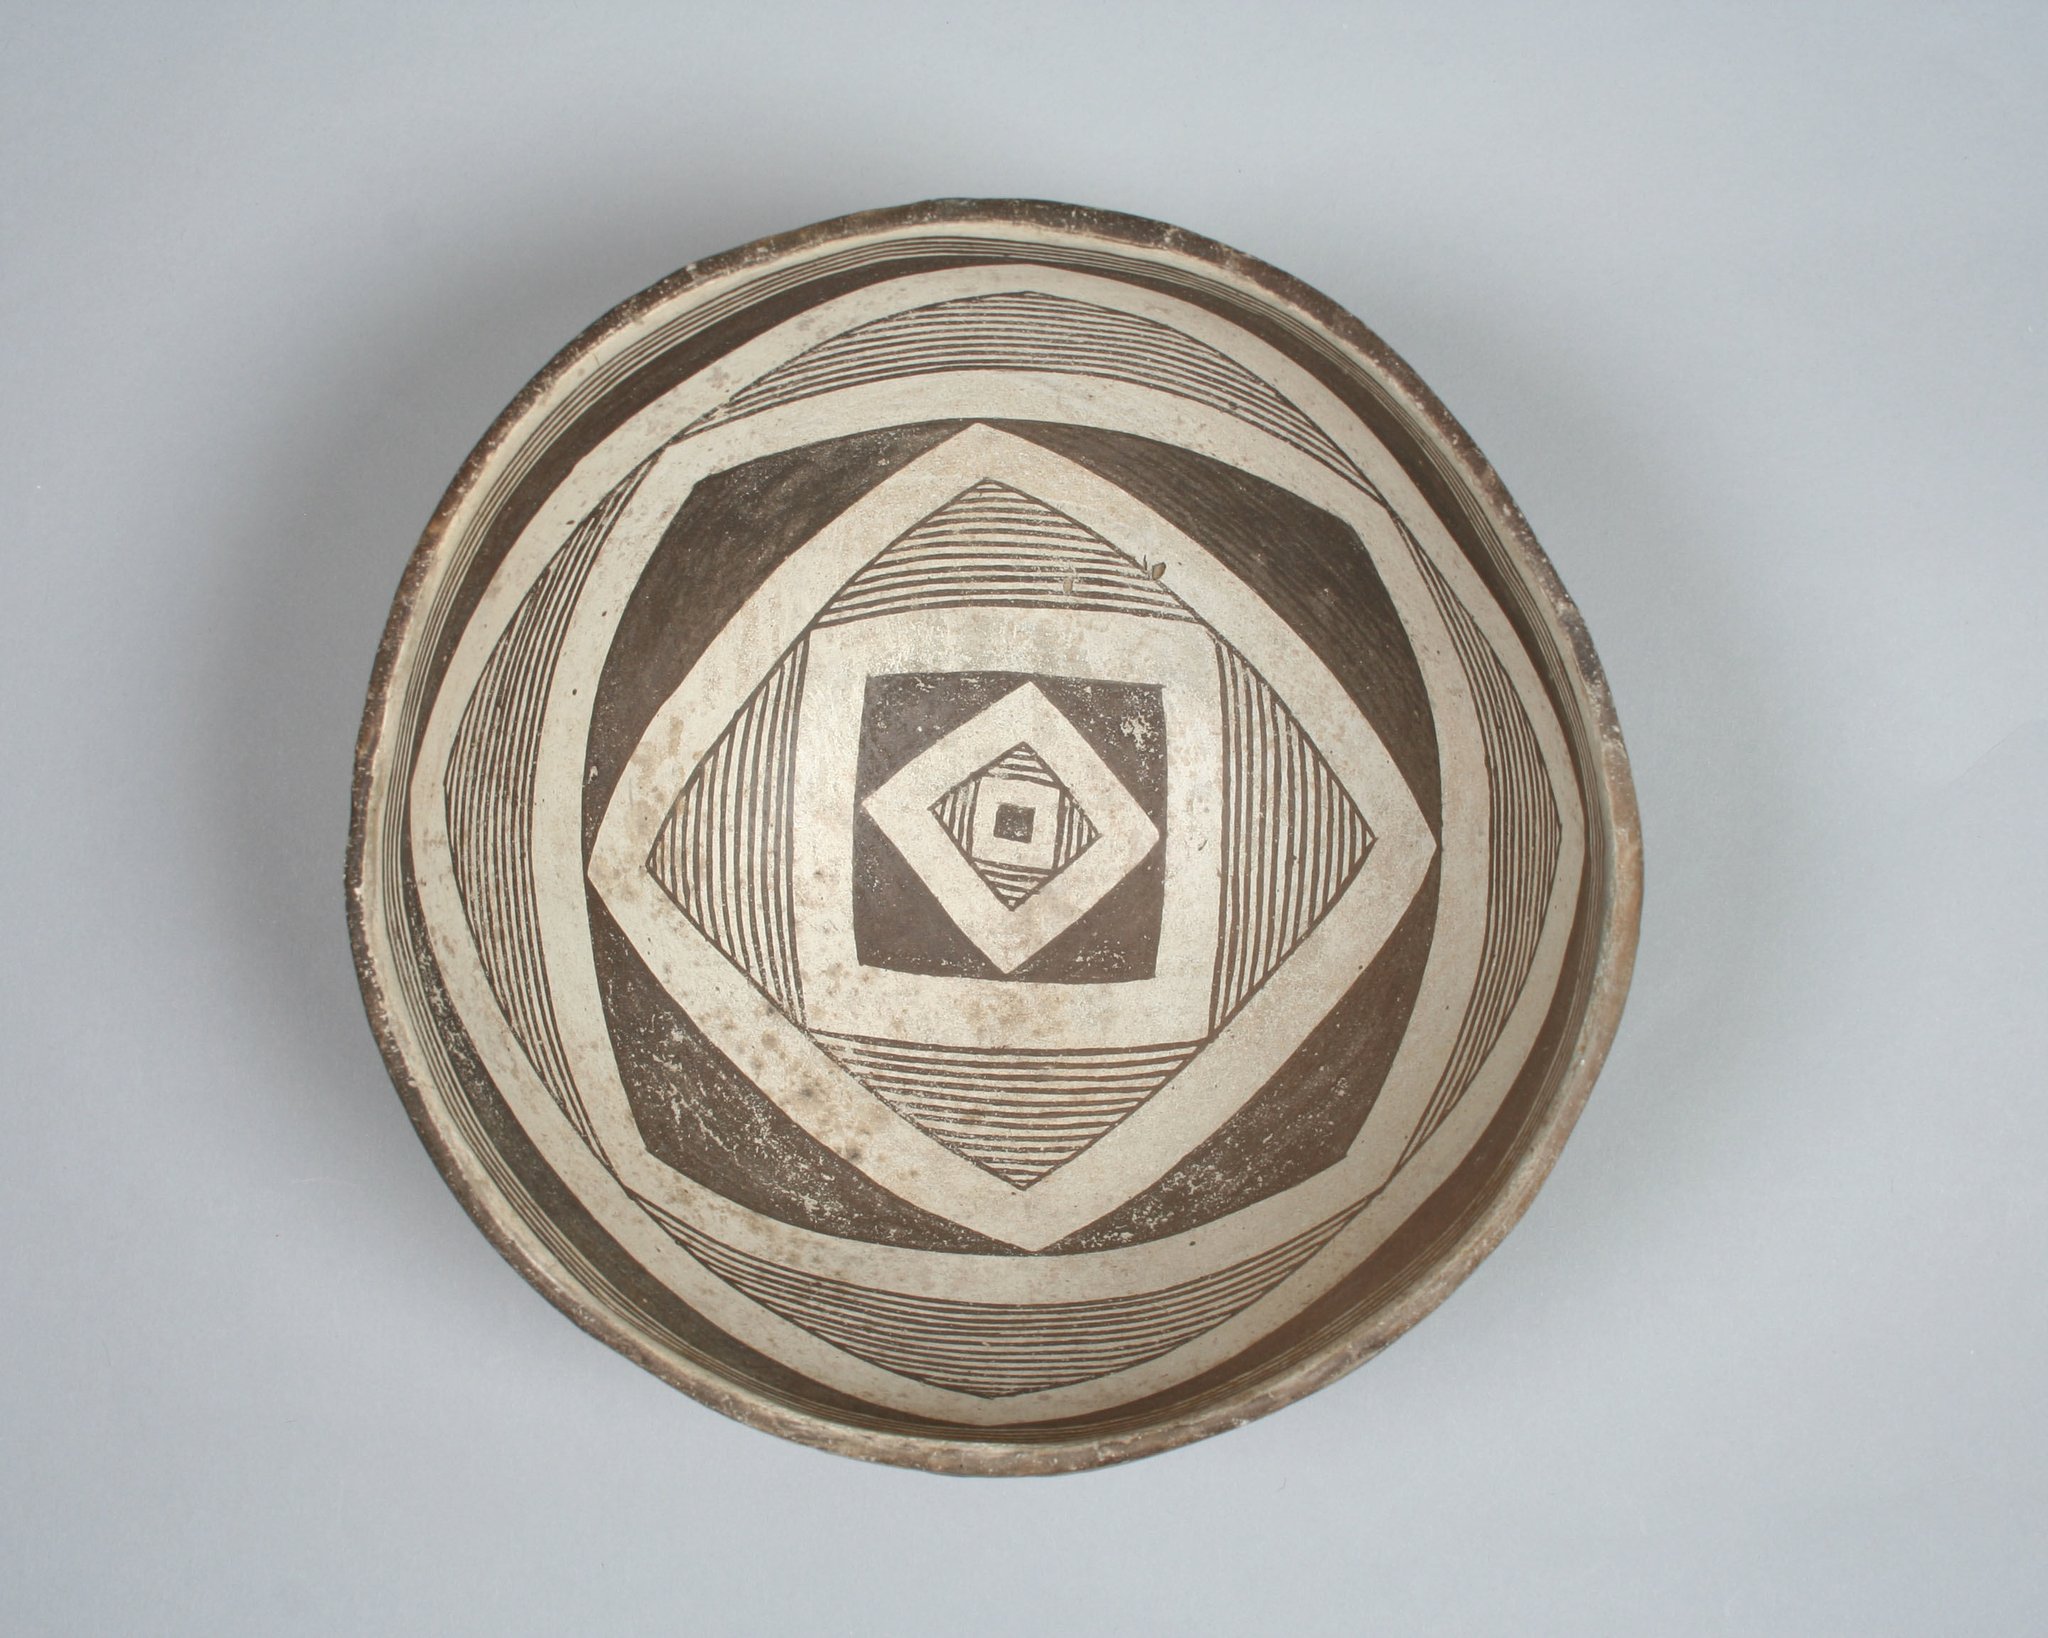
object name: bowl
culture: mimbres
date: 901-1200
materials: ceramic, pigment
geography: united states